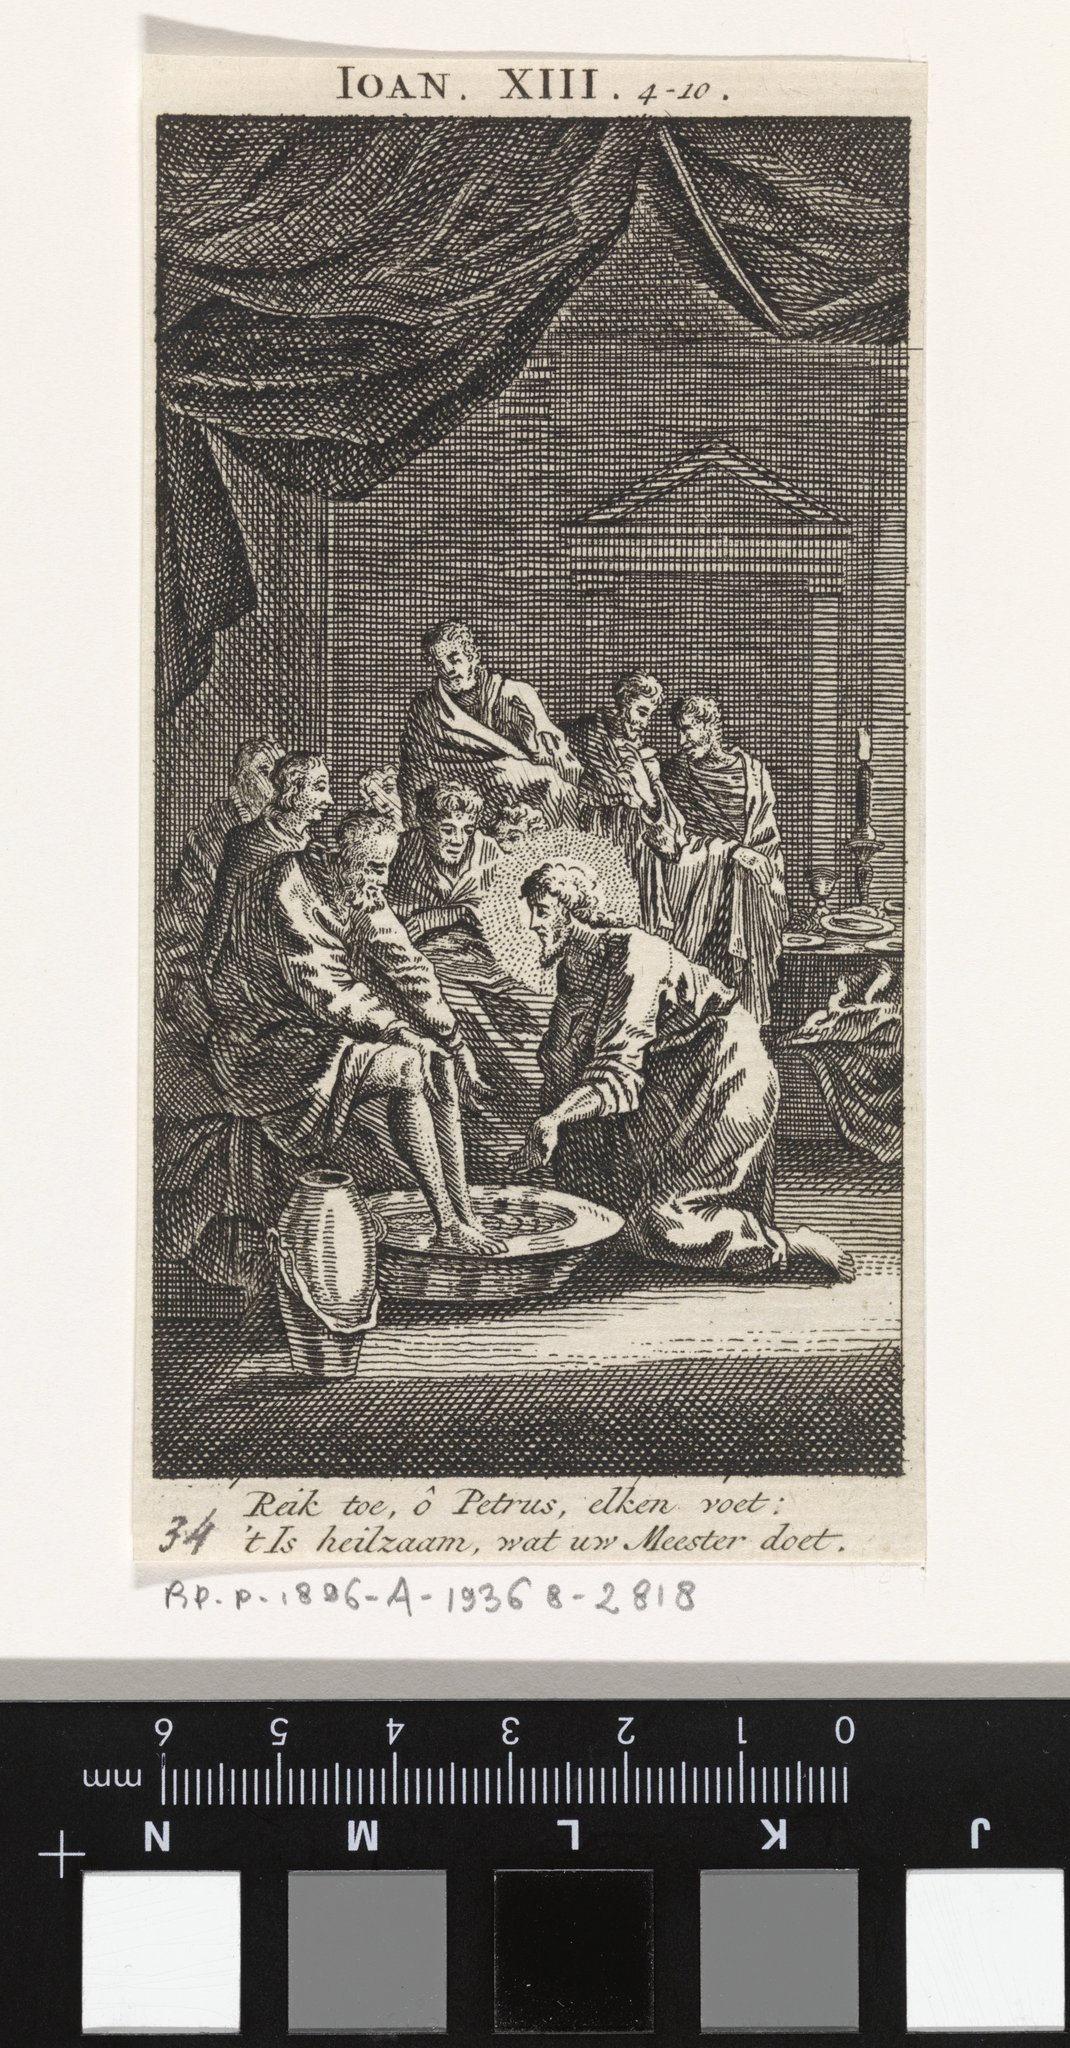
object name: print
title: Voetwassing van Petrus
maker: Anonymous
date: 1712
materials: paper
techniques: etching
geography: amsterdam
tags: christ washes peter's feet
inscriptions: collector's mark: Lugt 2228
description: Kopie van illustratie voor: Luyken, Jan. Bybel printen. Amsterdam: Pieter Arentsz. II (wed.) en Cornelis van der Sys, 1712, p. 33.